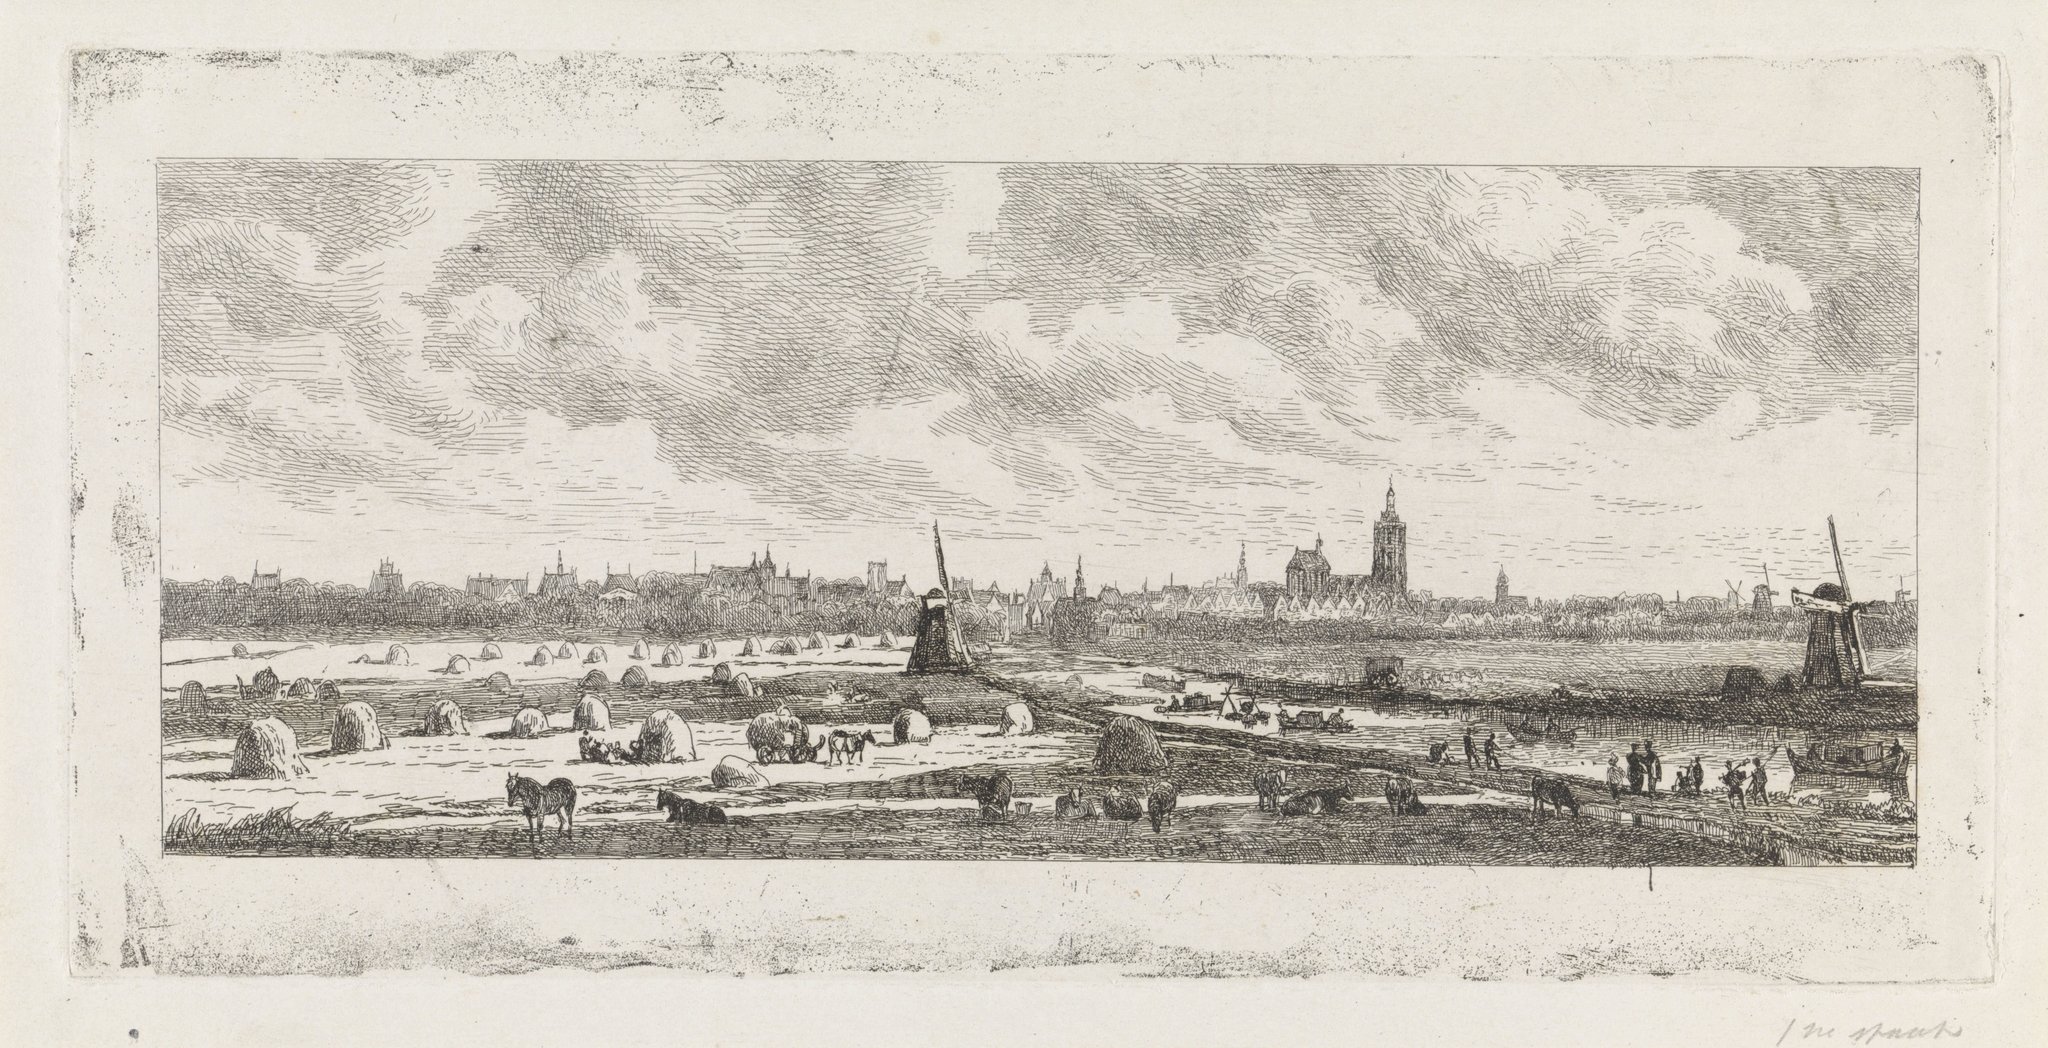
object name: print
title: Gezicht op 's Gravenhage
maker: julius jacobus van de sande bakhuyzen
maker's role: draughtsman, painter, print maker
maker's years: 1835-1925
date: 1845-1885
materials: paper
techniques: drypoint, etching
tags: prospect of city, town panorama, silhouette of city, the hague, delft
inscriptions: collector's mark: Lugt 2228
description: Gezicht op 's Gravenhage met op voorgrond de Delftse trekvaart.